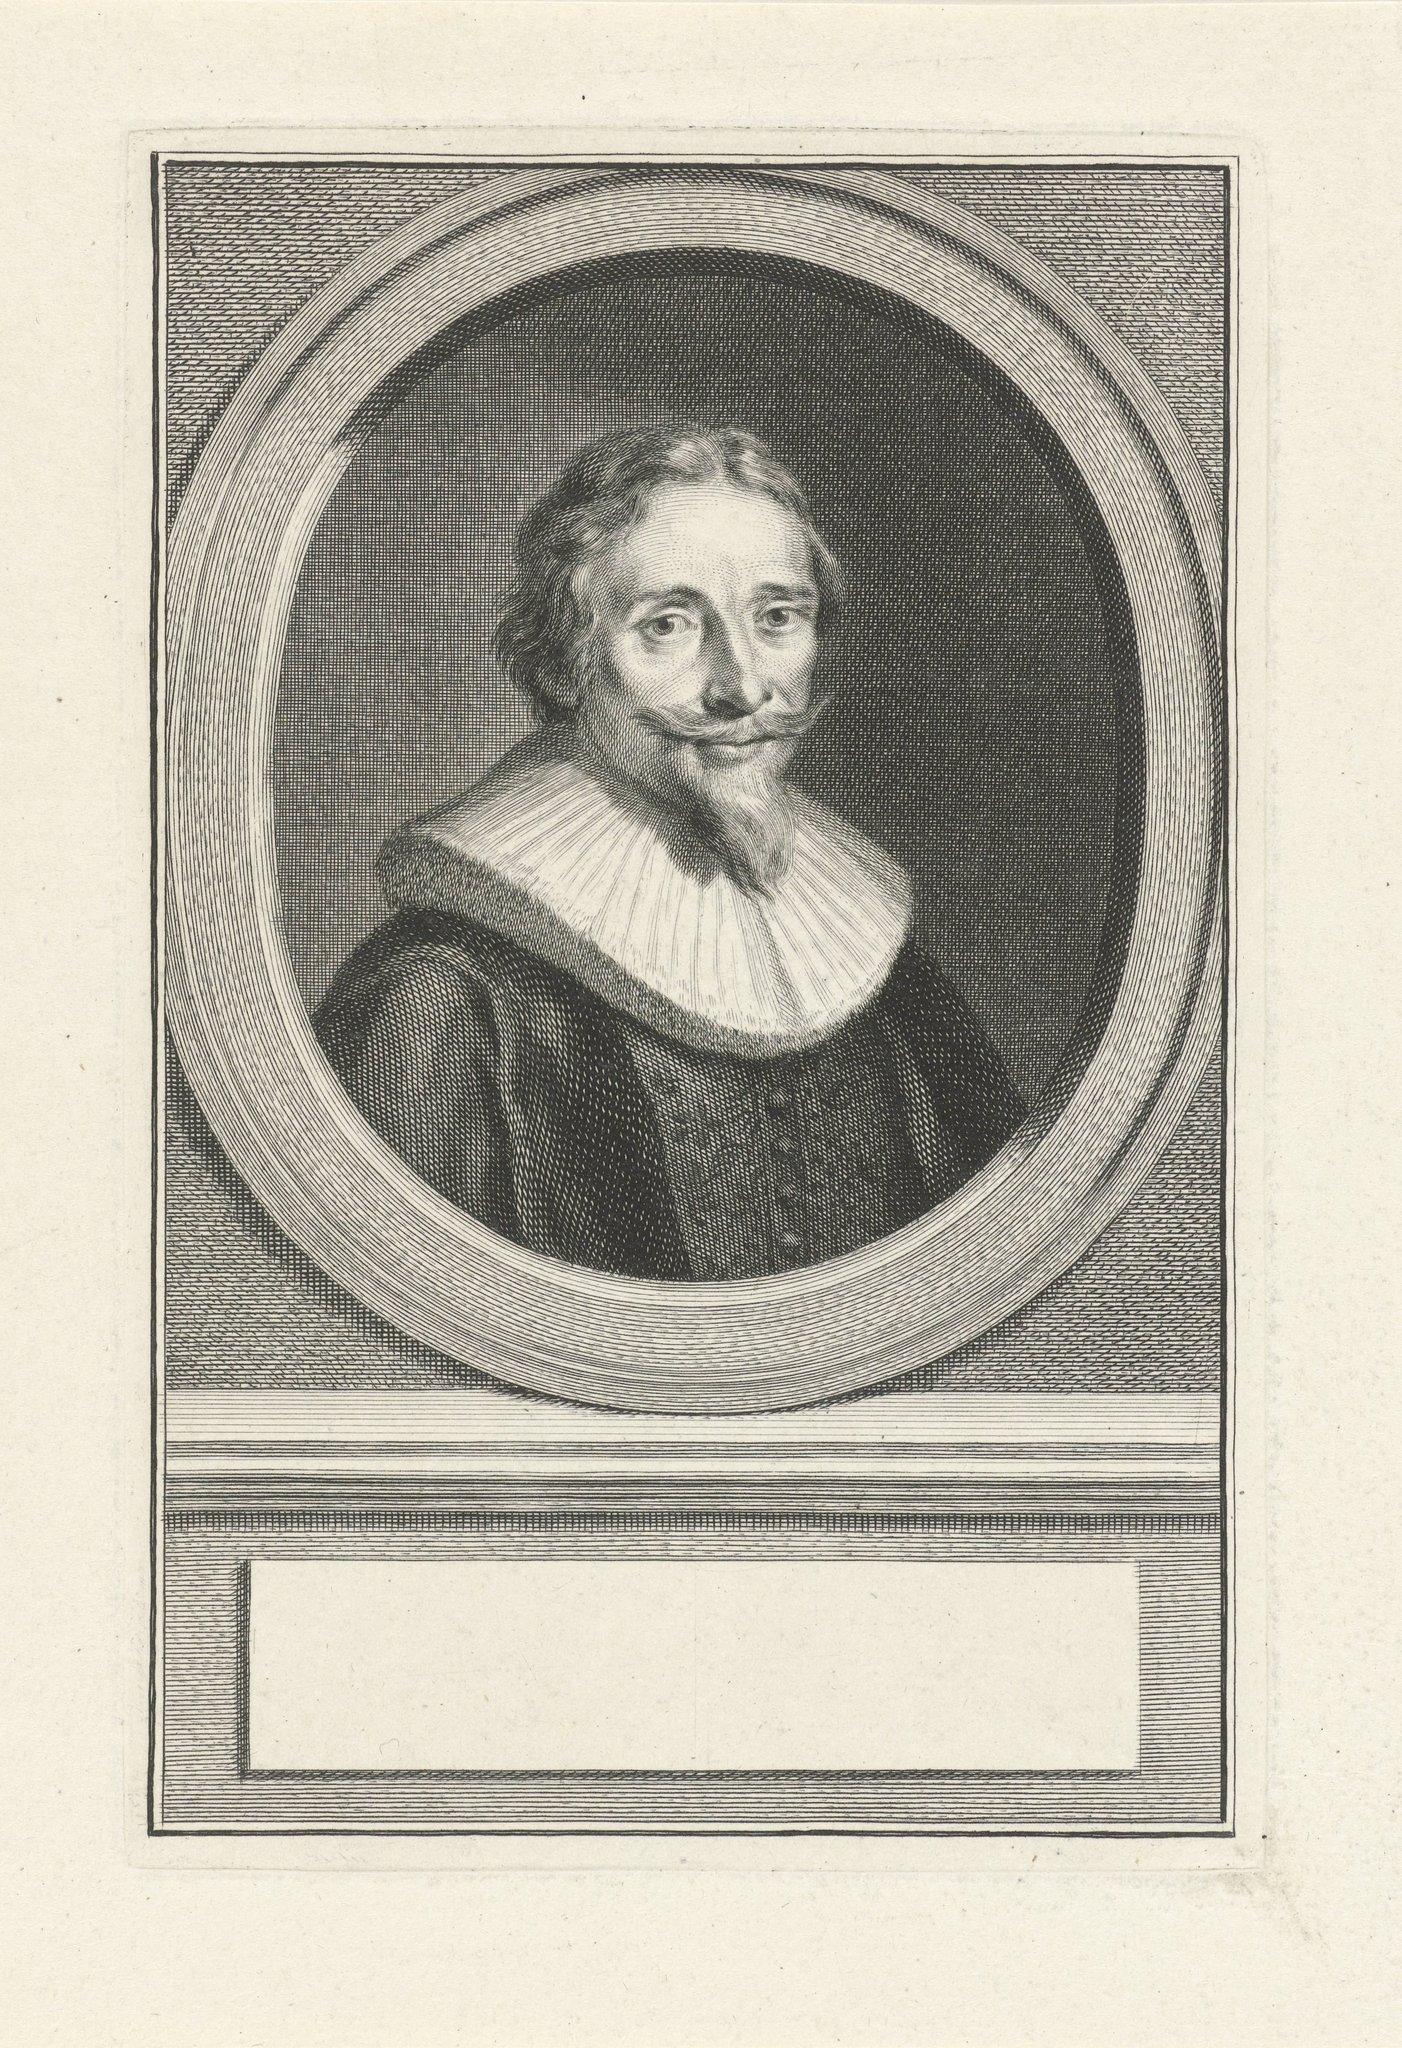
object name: print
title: Portret van Hugo de Groot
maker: jacob houbraken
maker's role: draughtsman, print maker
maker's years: 1698-1780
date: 1747-1759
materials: paper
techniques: engraving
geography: amsterdam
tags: delft, hugo de groot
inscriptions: collector's mark: Lugt 240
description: Proefdruk van de prent gebruikt in: Jan Wagenaar, Vaderlandsche historie, vervattende de geschiedenissen der nu Vereenigde Nederlanden, inzonderheid die van Holland (...), 21 delen. Amsterdam, Isaak Tirion, 1749-59.